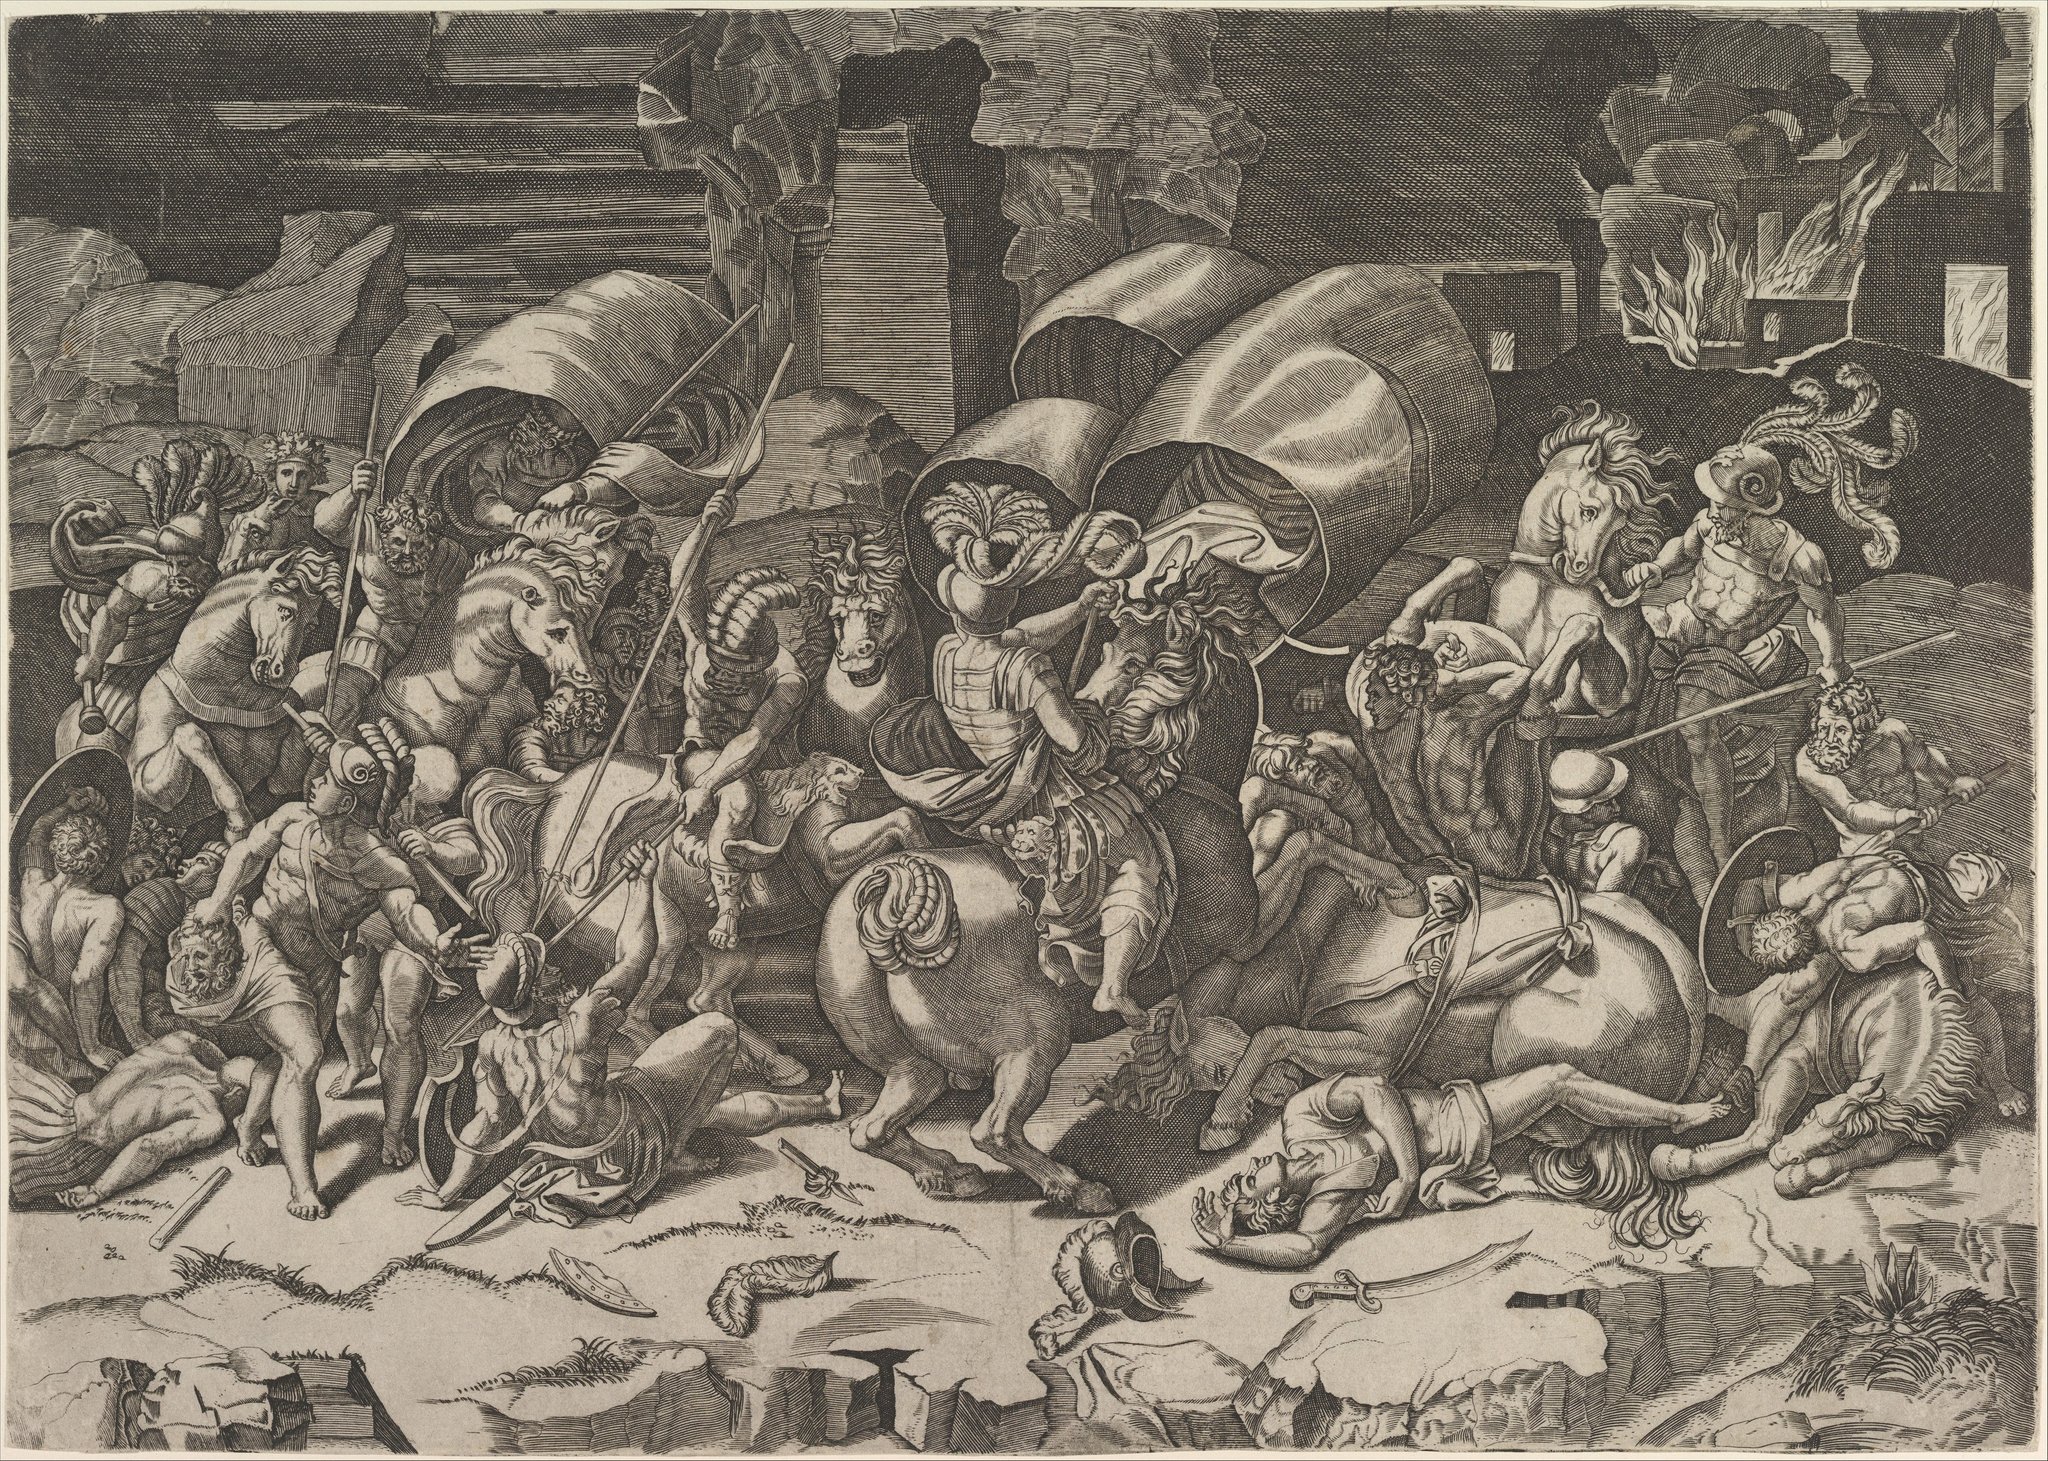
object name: print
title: Battle with a Cutlass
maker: marco dente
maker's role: artist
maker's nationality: italian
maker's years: 1515-1527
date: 1515-1527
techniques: engraving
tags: battles,weapons,corpses,men,horses